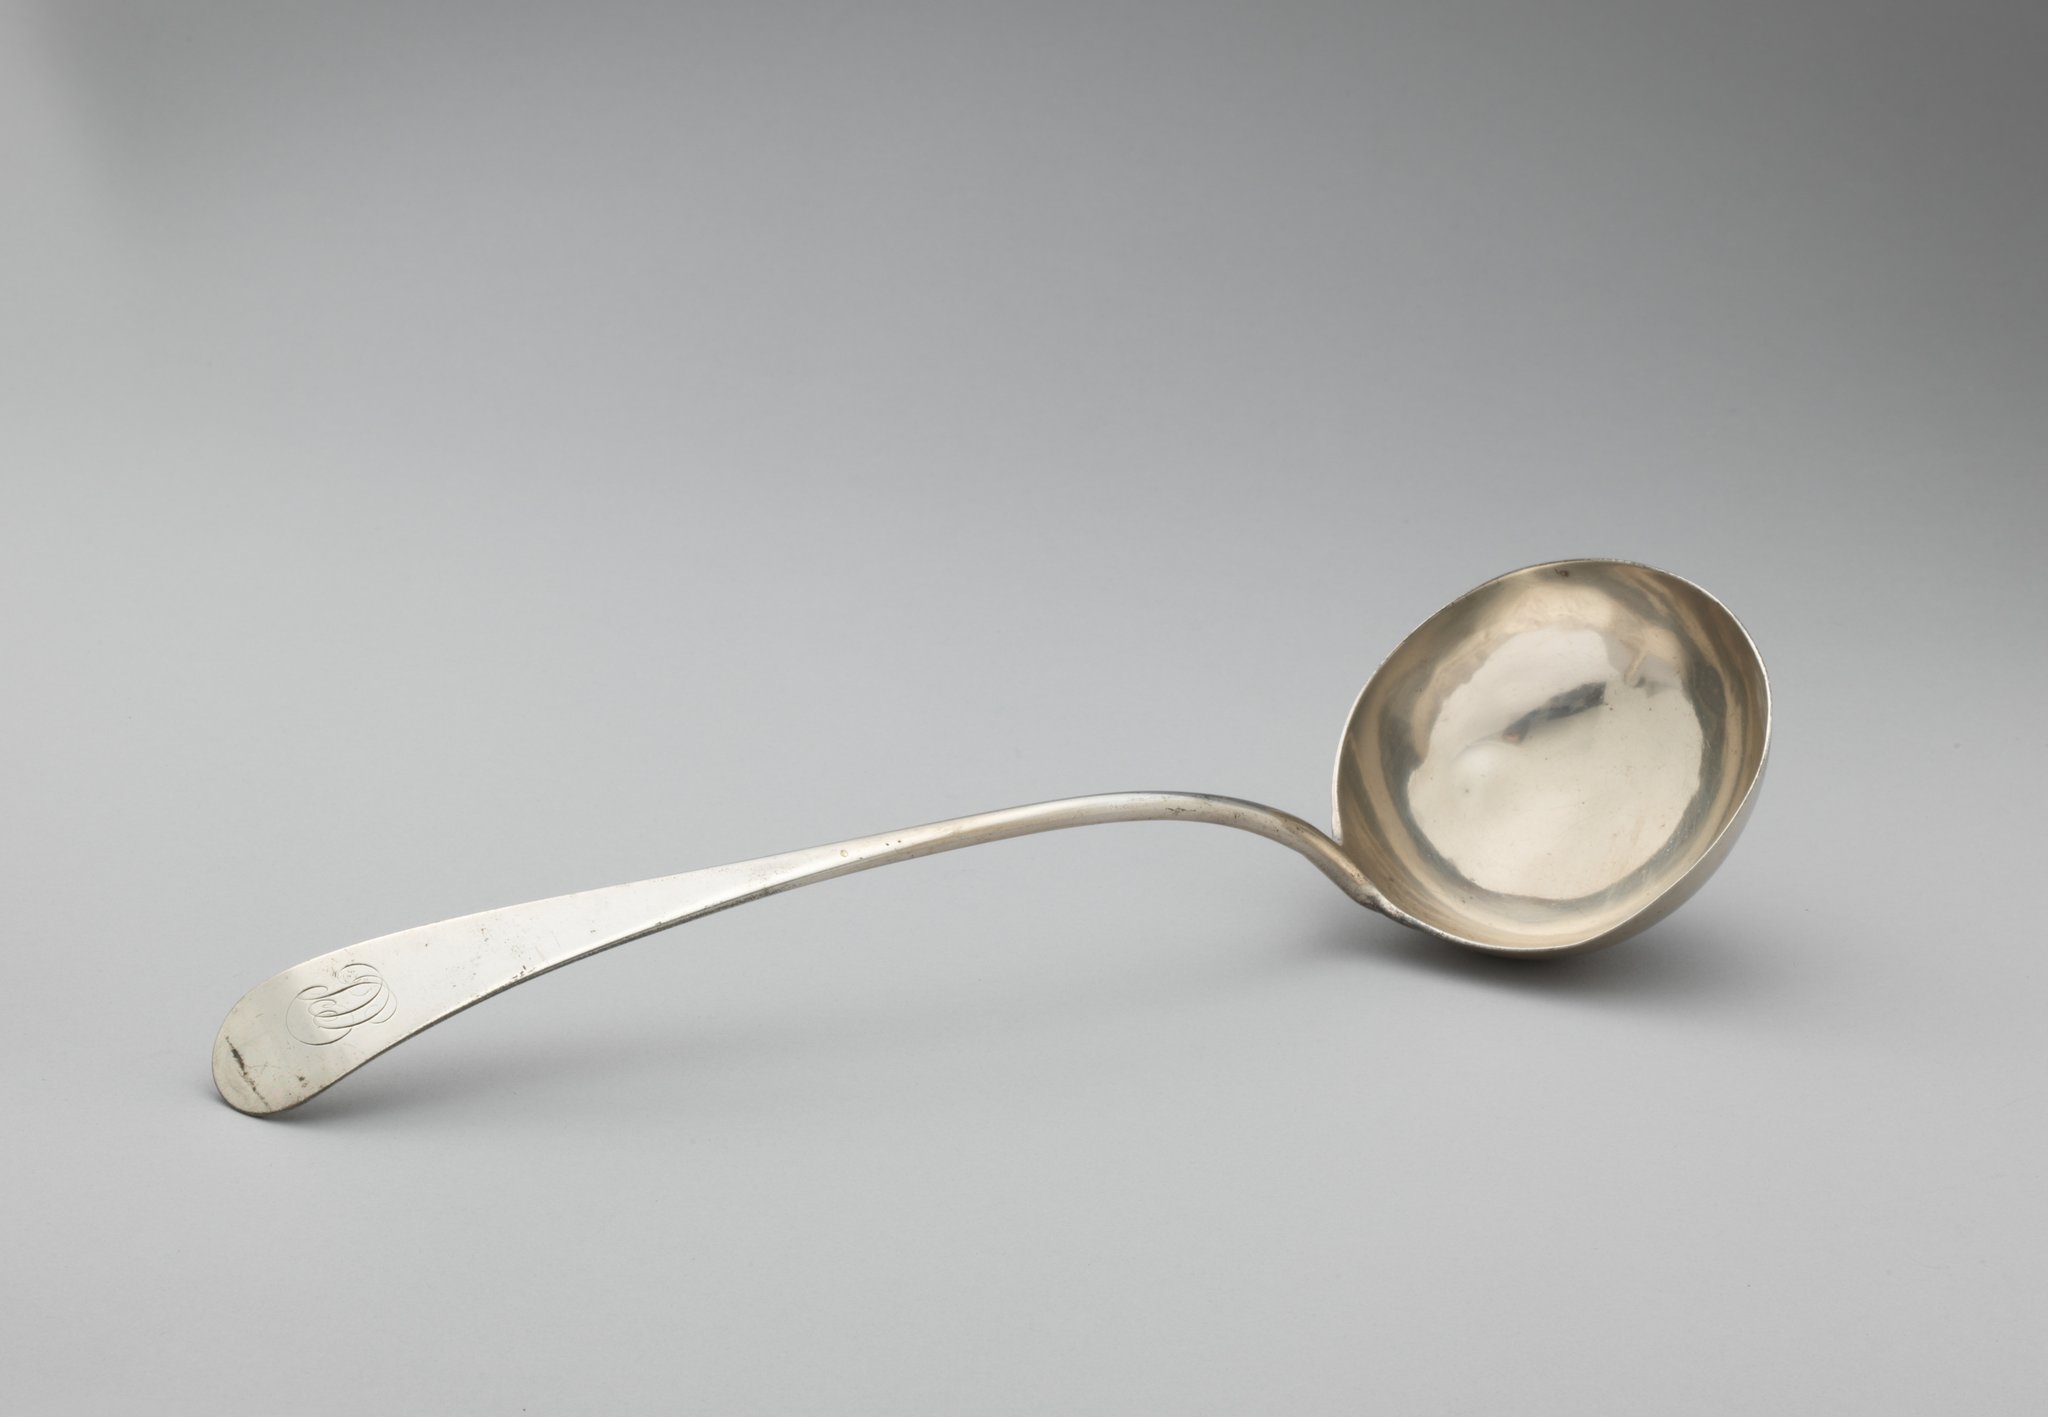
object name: ladle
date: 1760-1761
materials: silver